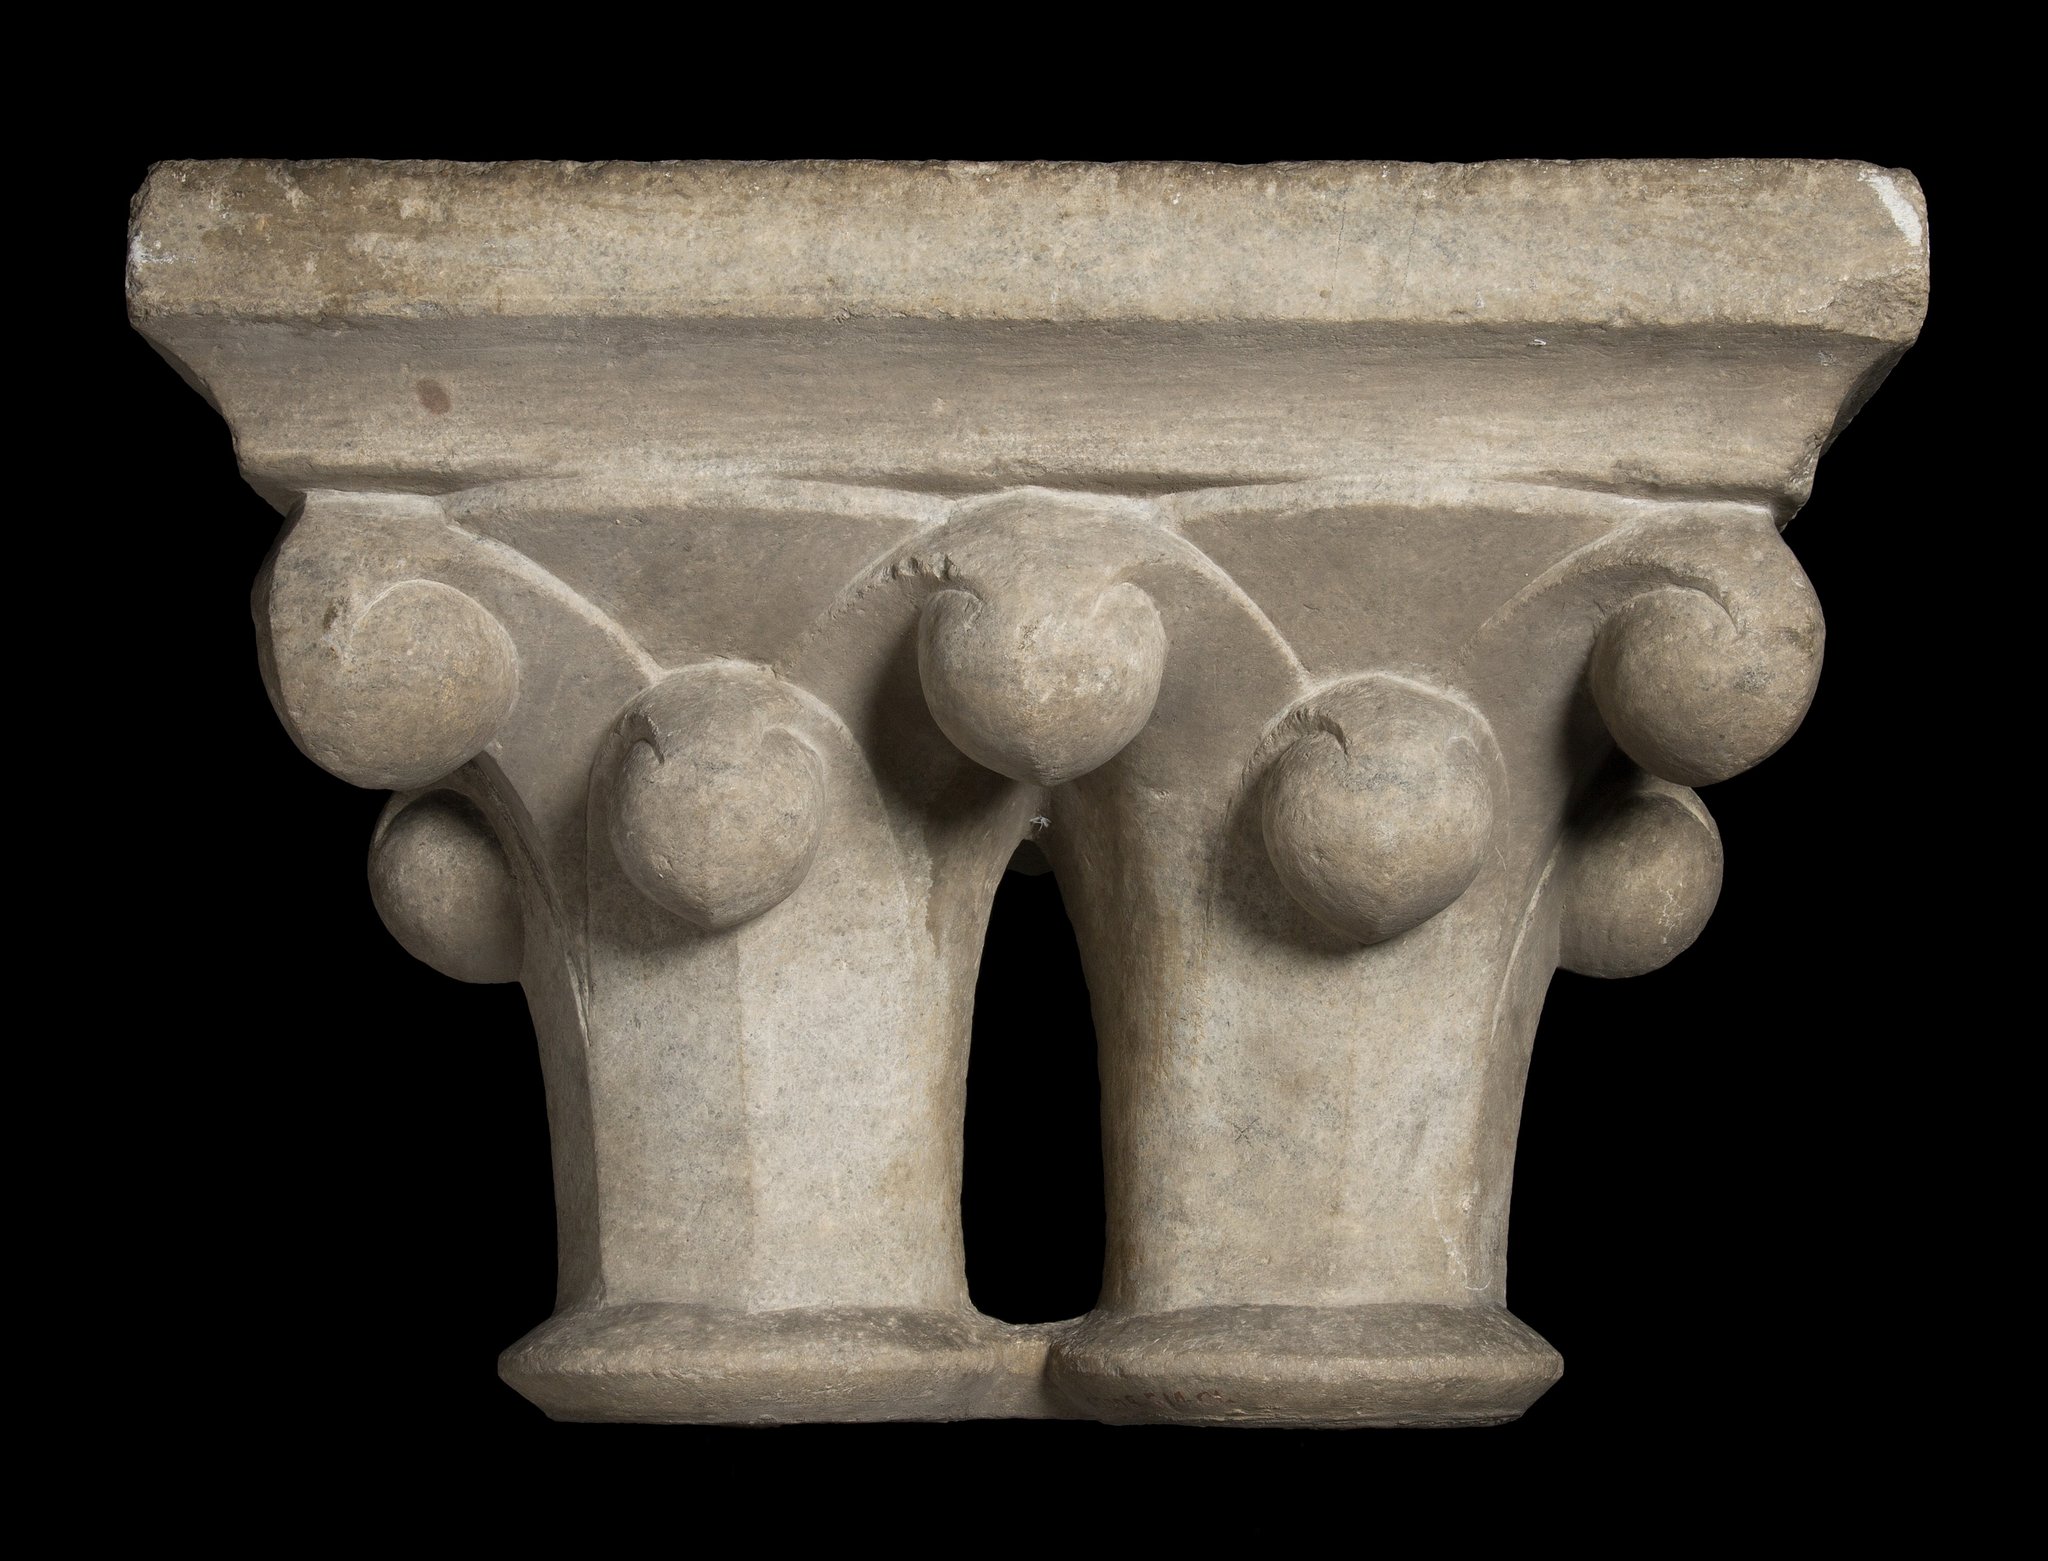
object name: double column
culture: french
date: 1201-1400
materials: marble